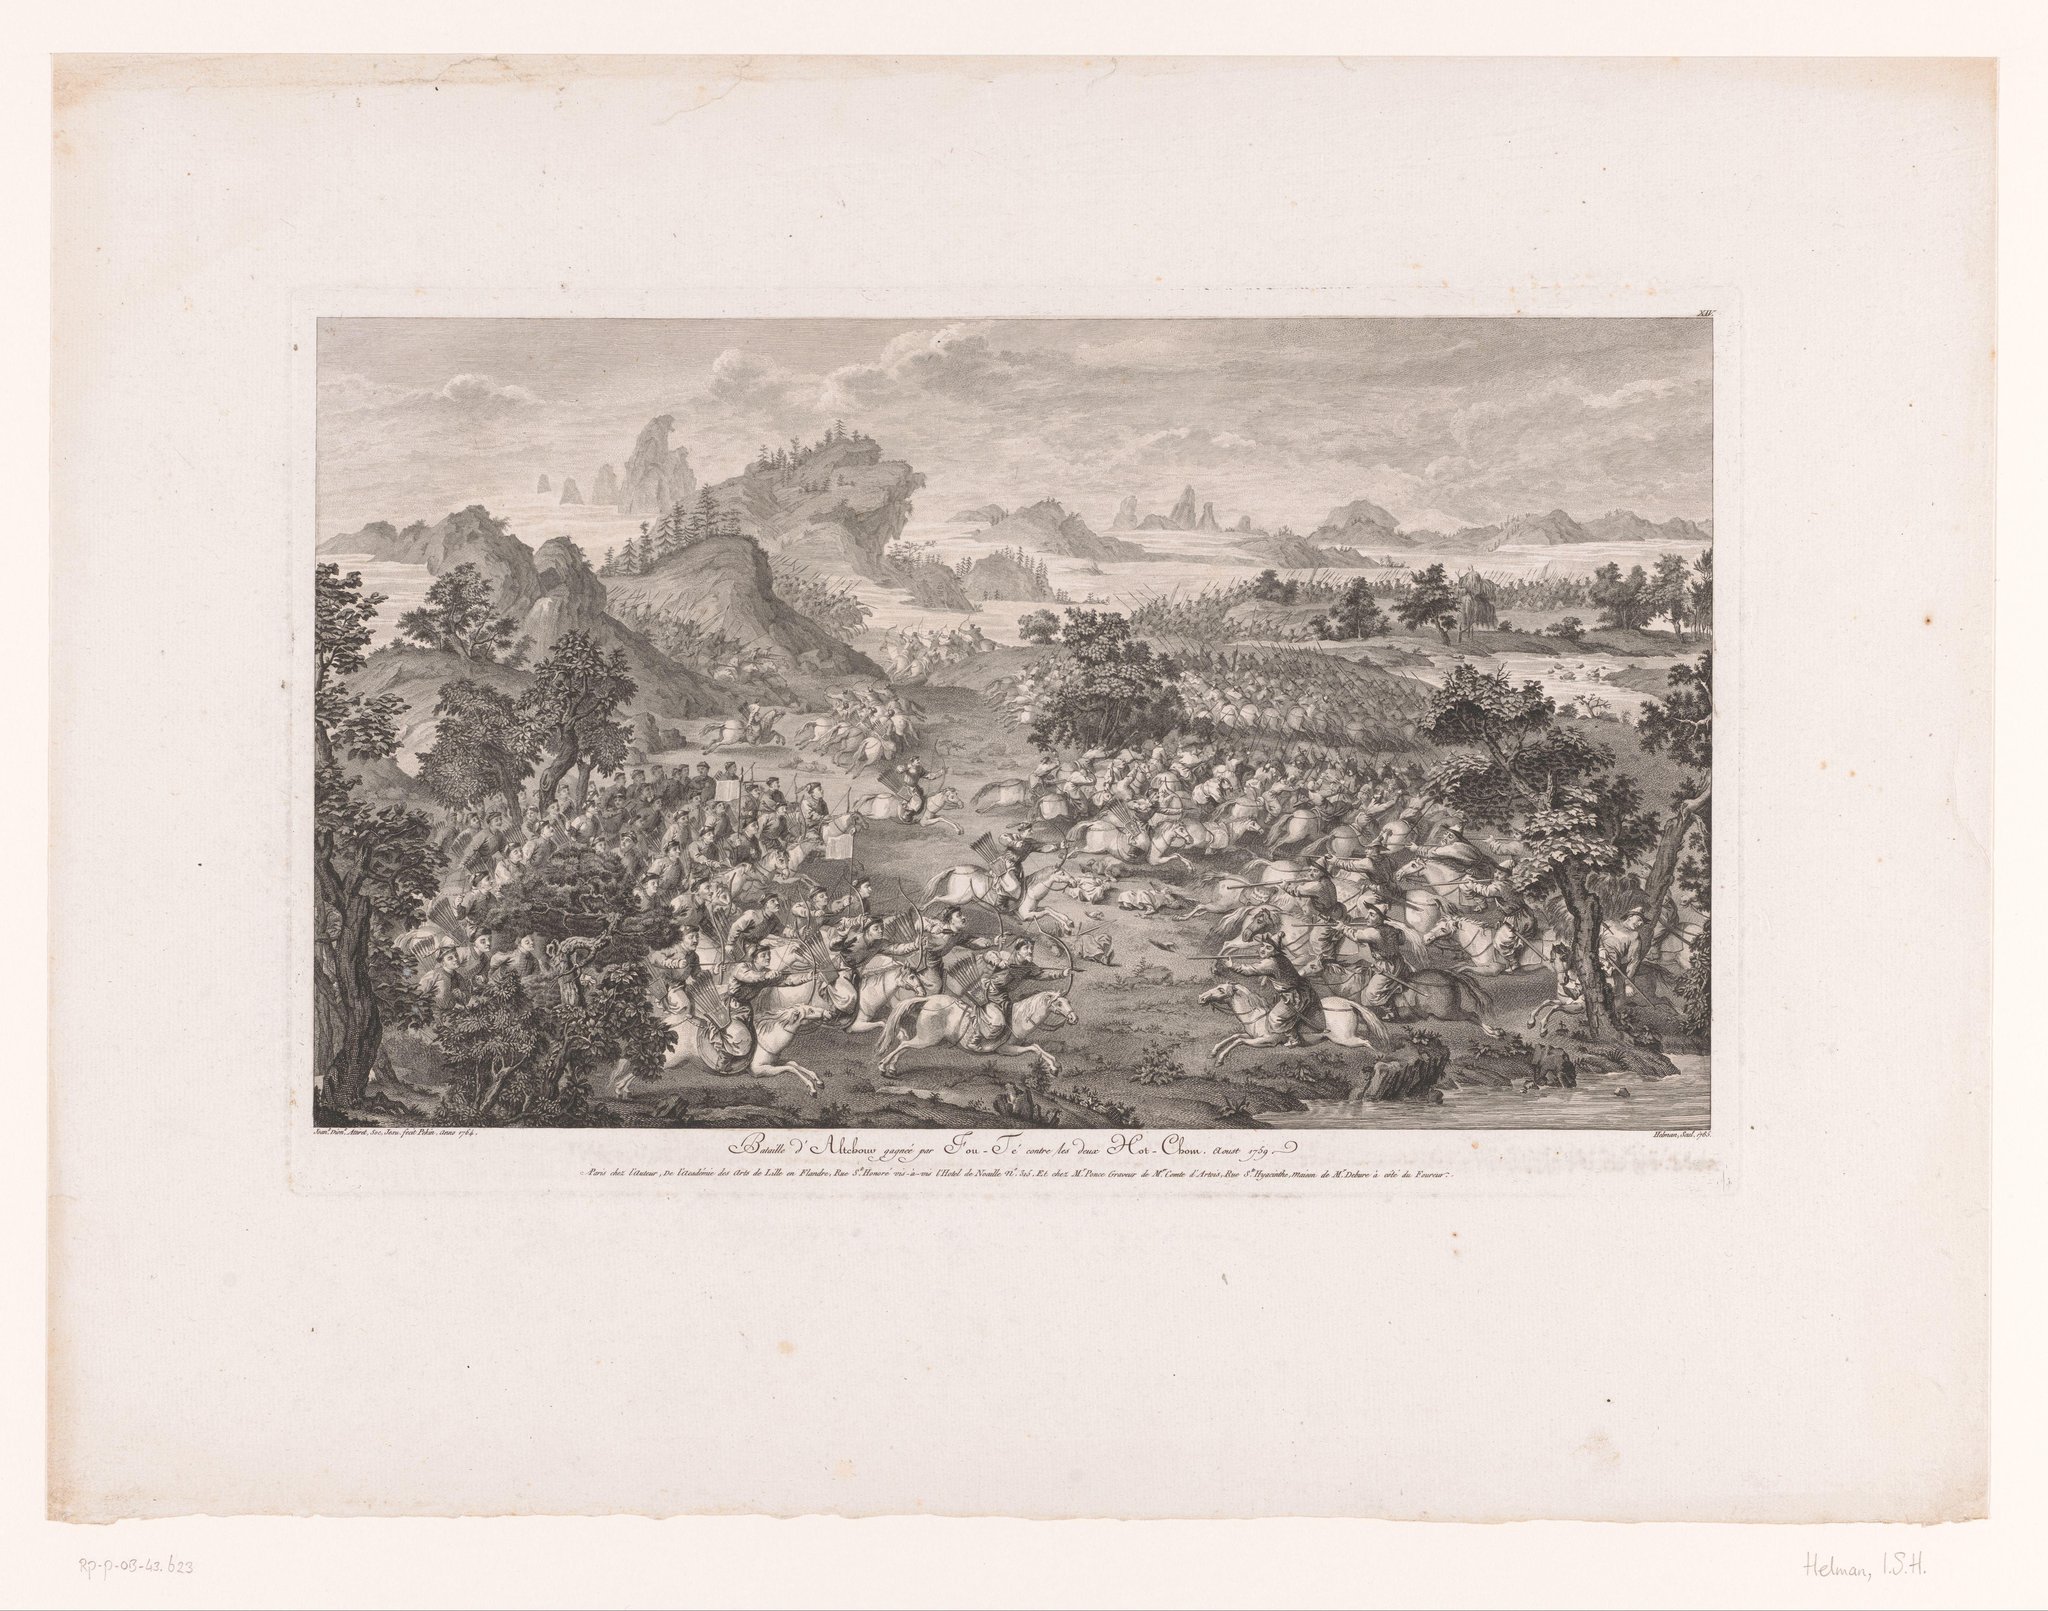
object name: print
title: Slag van Altchouv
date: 1785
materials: paper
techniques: engraving, etching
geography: paris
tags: battle (+ artillery), battle (+ cavalry, horsemen)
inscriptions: collector's mark: Lugt 2228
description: Prent uit een versie van de serie 'Conquêtes de l'Empereur de la Chine' met afbeeldingen van de veroveringen van keizer Qianlong van China, uitgegeven door Helman tussen 1783-1785. Voor twee bladen met bijbehorende beschrijvende tekst, zie RP-P-OB-43.629 en RP-P-OB-43.630.